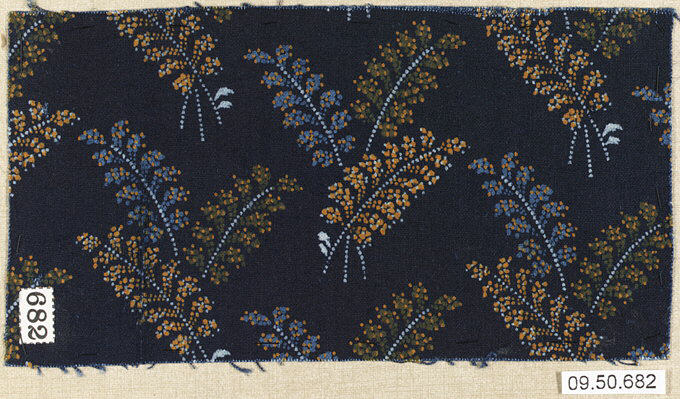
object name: piece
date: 1801-1900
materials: cotton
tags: leaves